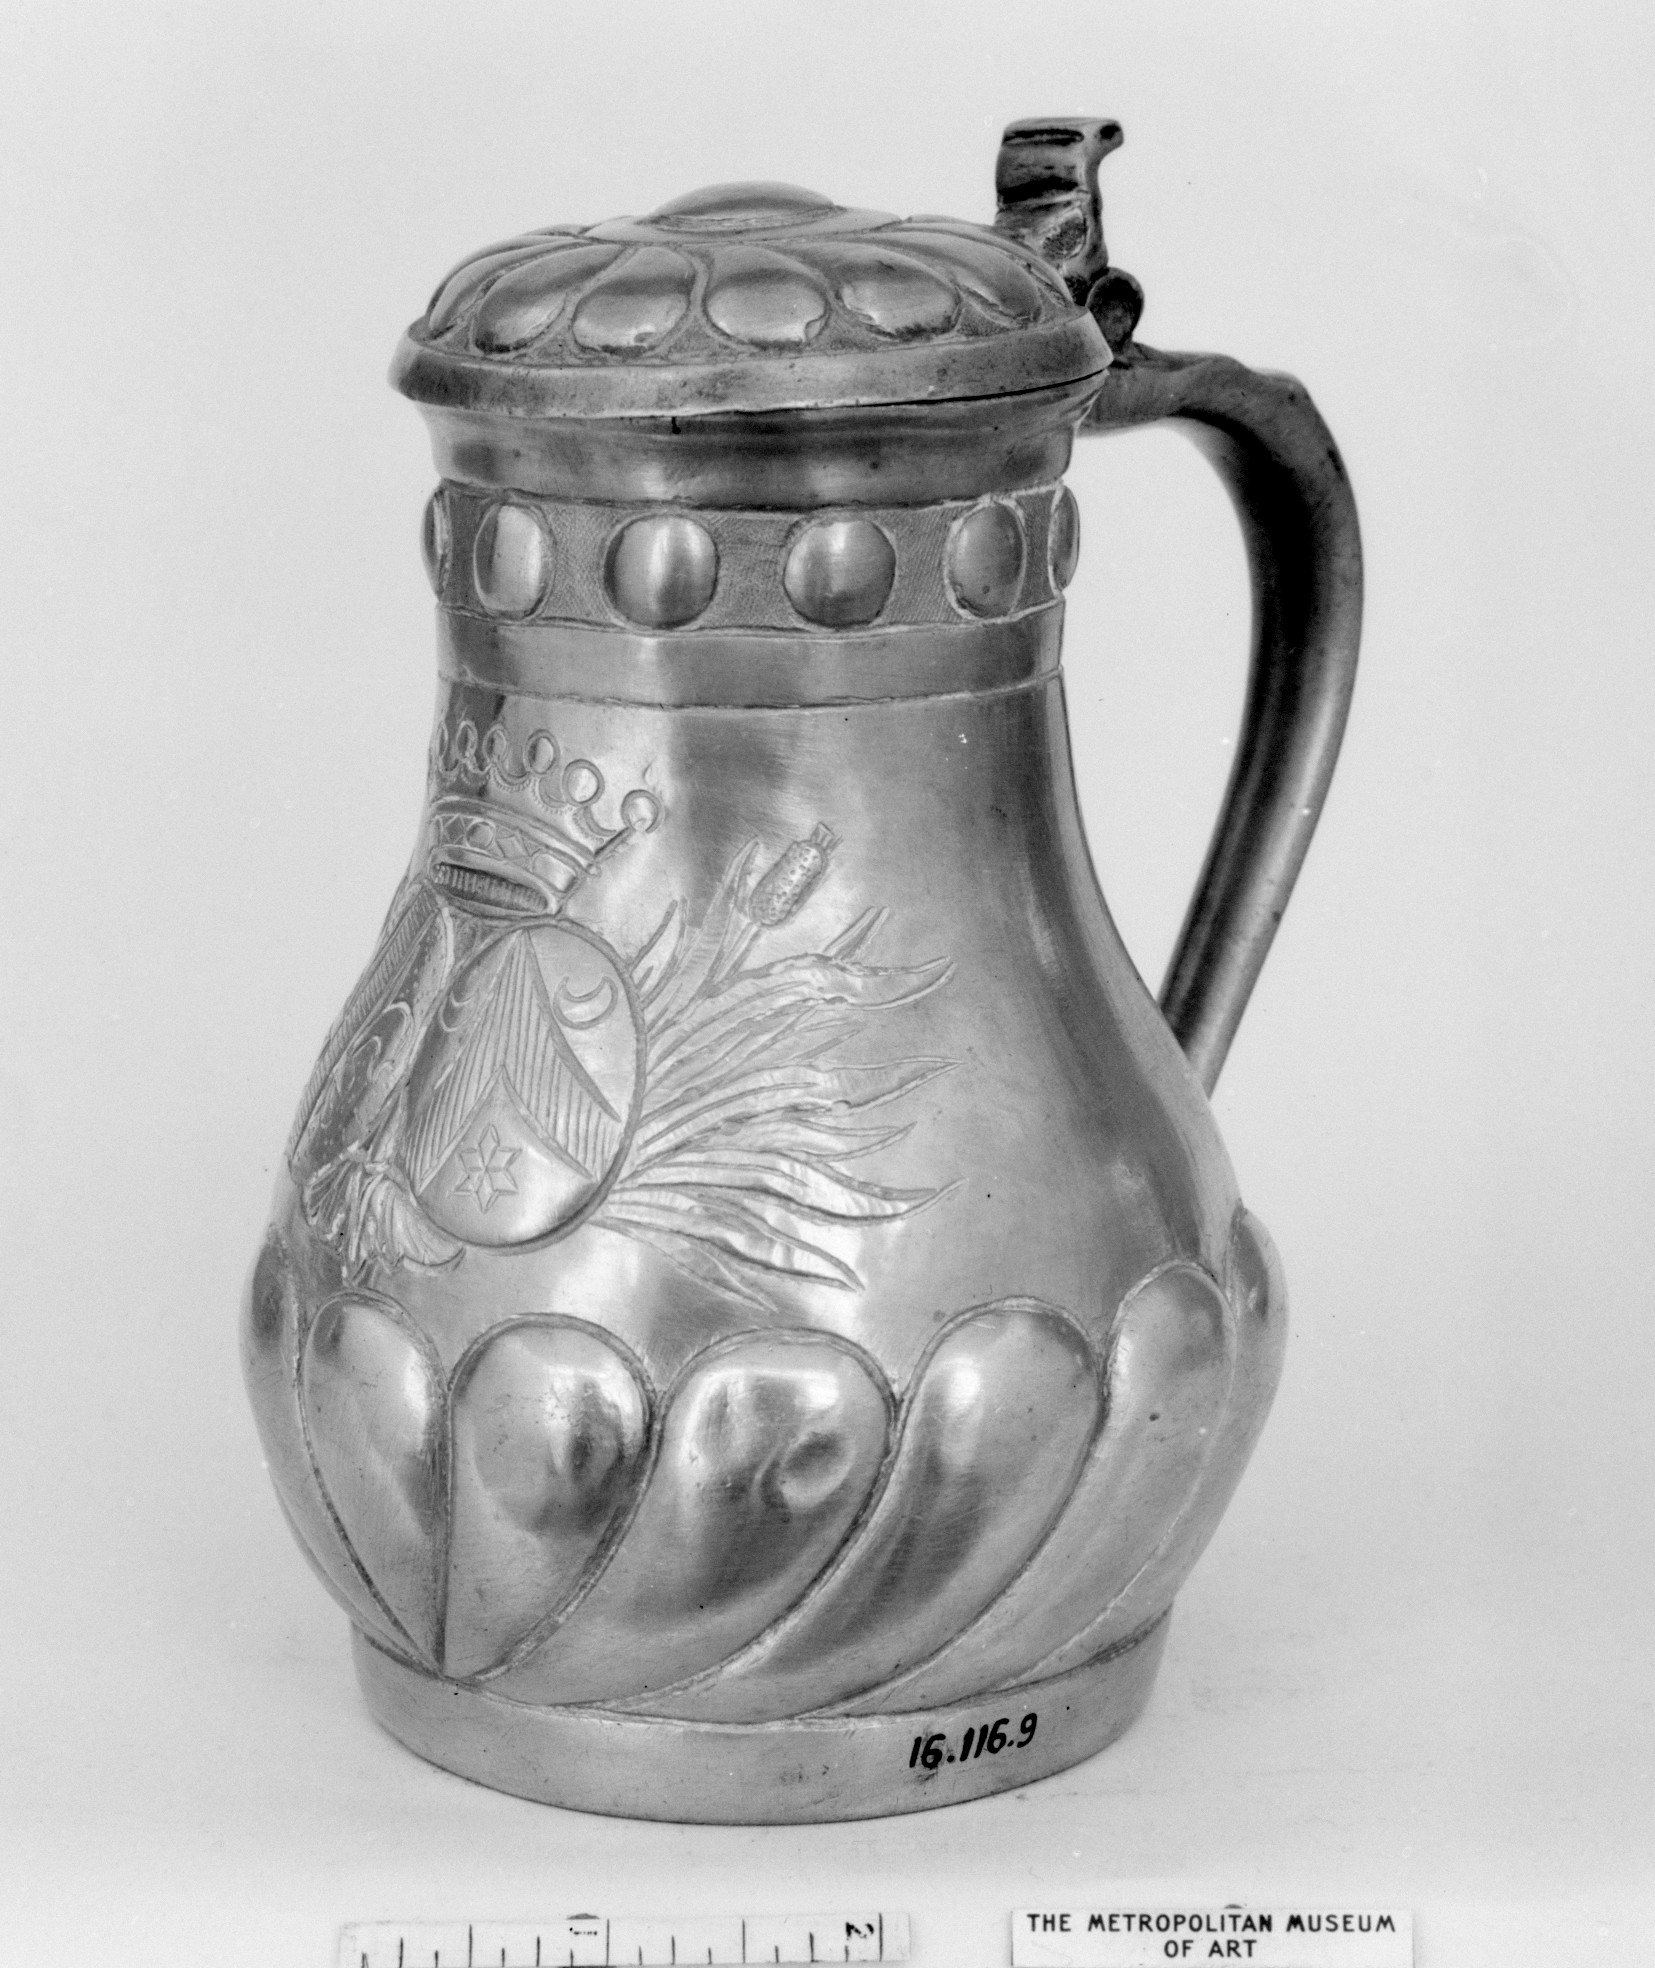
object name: flagon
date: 1701-1800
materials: pewter